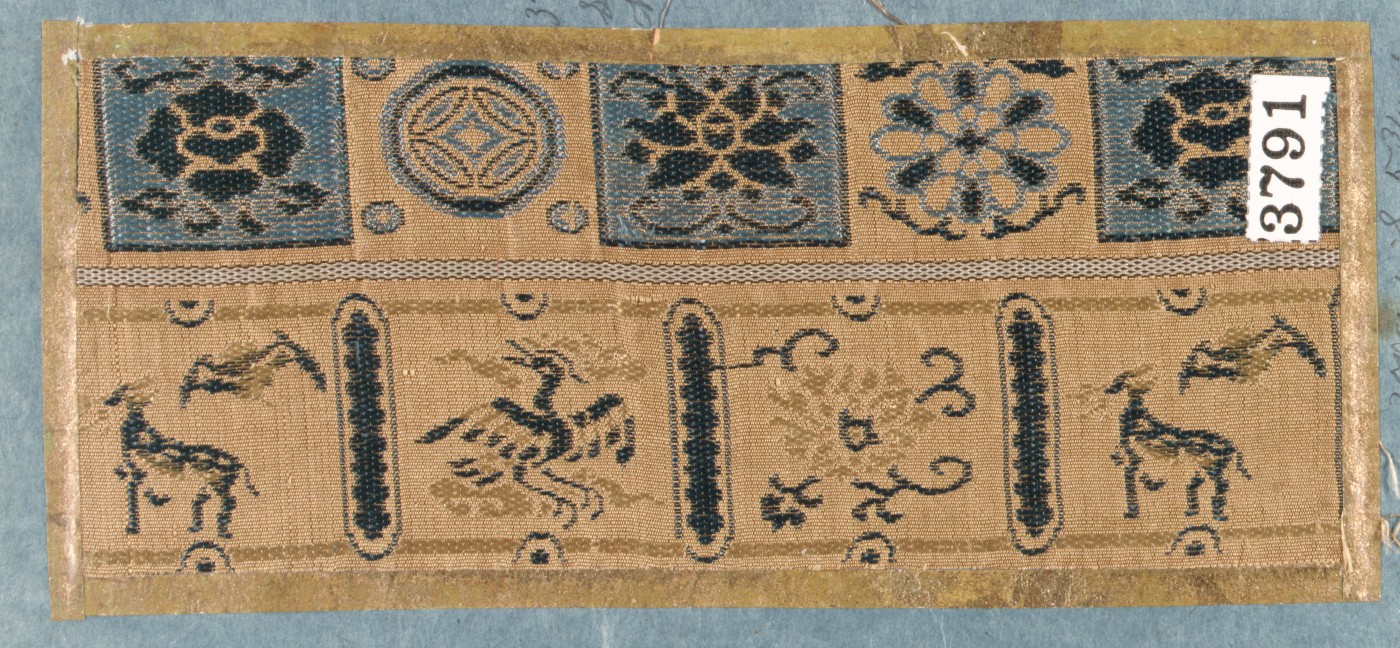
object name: sample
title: Textile Sample from Sample Book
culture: japanese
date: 1801-1900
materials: silk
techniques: tapestry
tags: animals,bats,birds,flowers